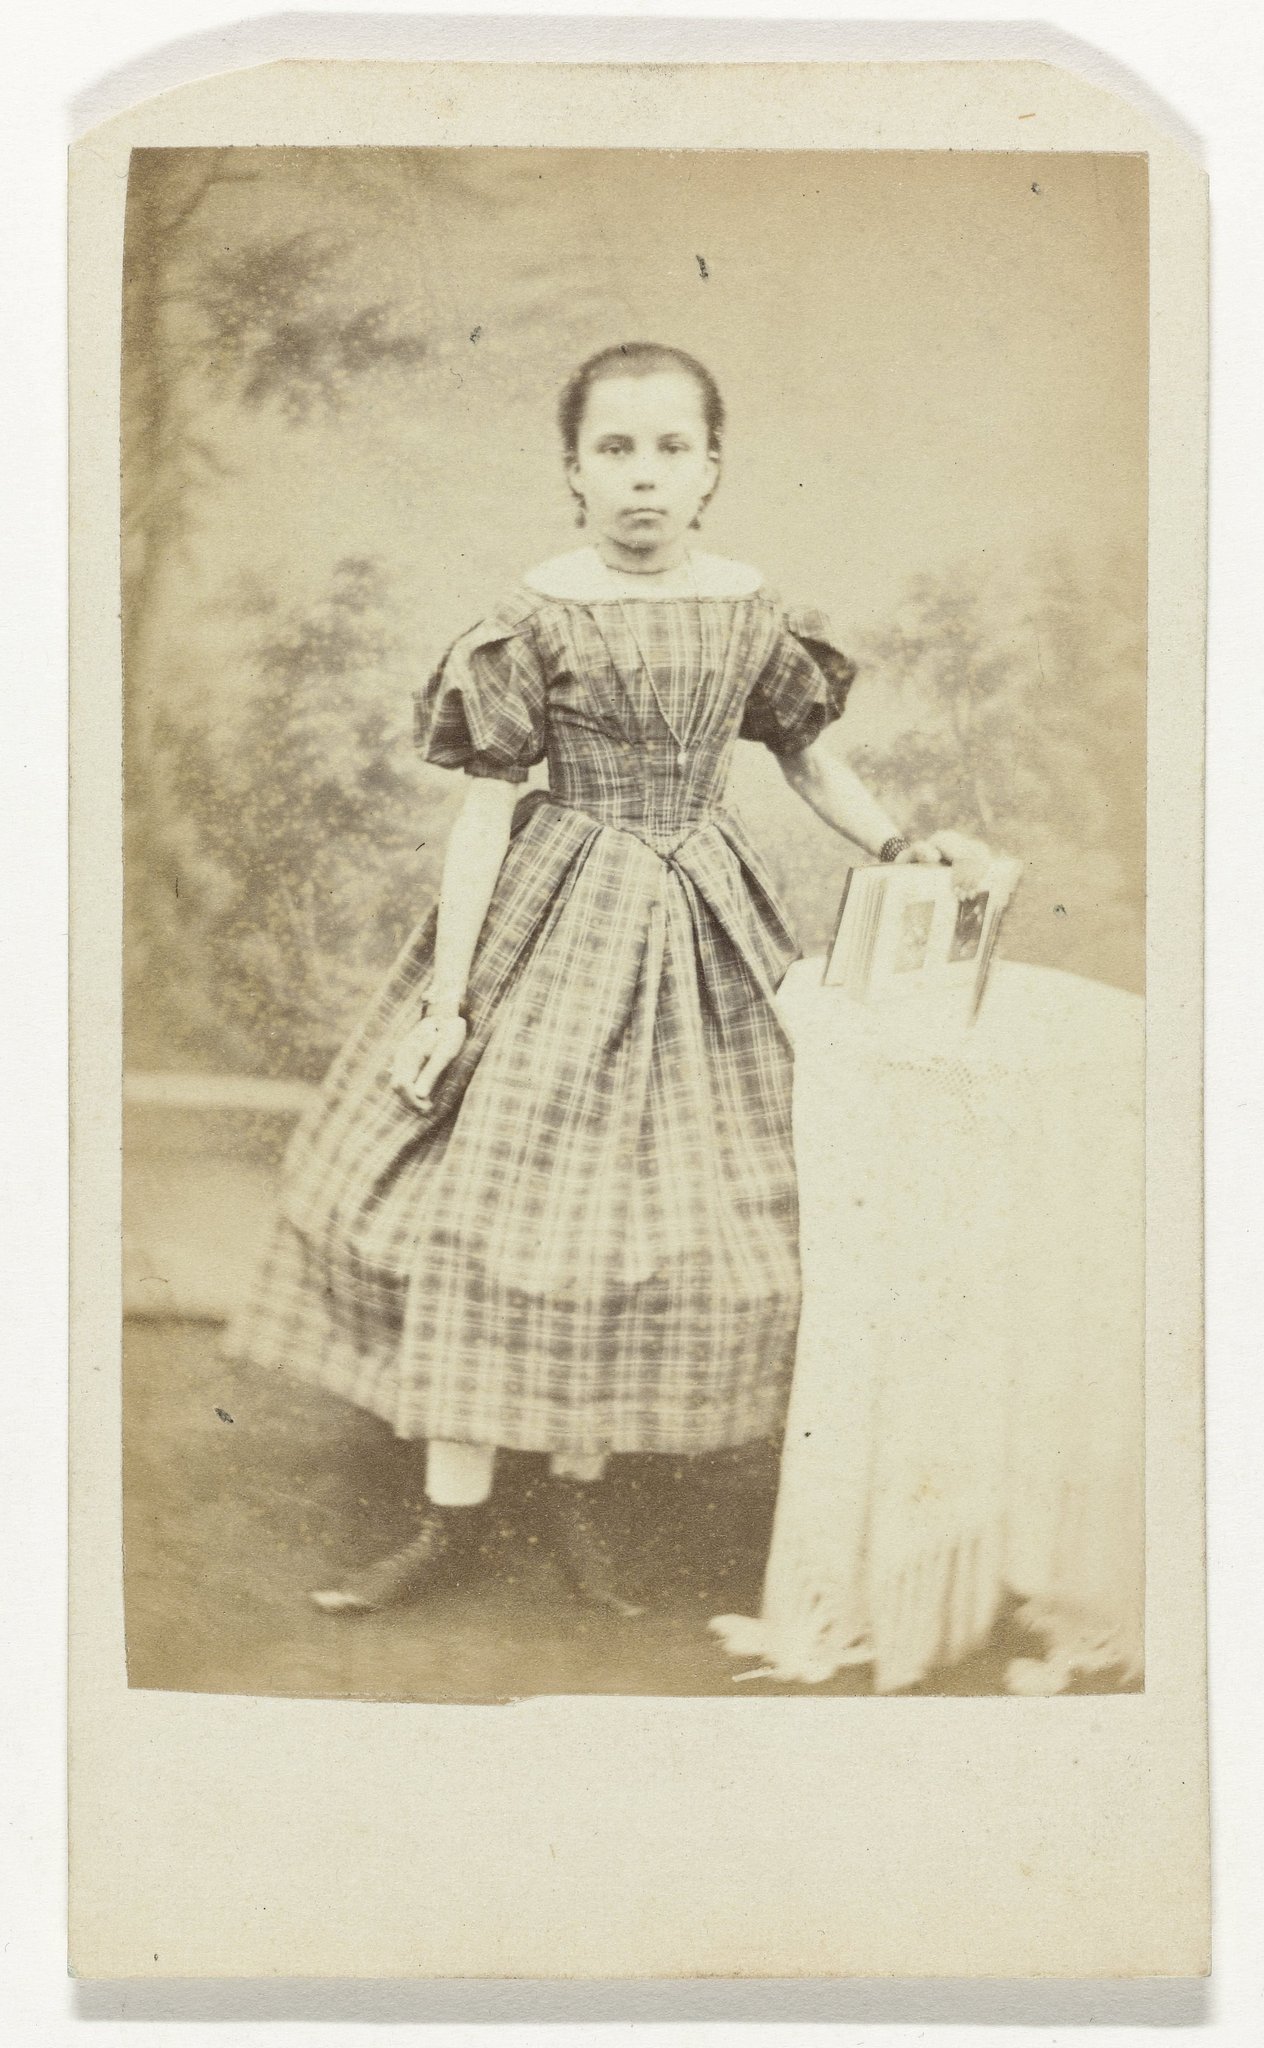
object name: photograph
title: Portret van een meisje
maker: j. wijnman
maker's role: fotograaf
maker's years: 1844-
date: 1866-1870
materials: cardboard, paper, photographic support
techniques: albumen print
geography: amsterdam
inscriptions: address: ‘PHOTOGRAFISCH ATELIER // van // J. WIJNMAN // Halsteeg No. 248 // AMSTERDAM’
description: Portret van een meisje, staande met een boek naast een tafel met een licht kleed erover, voor een geschilderde achtergrond.